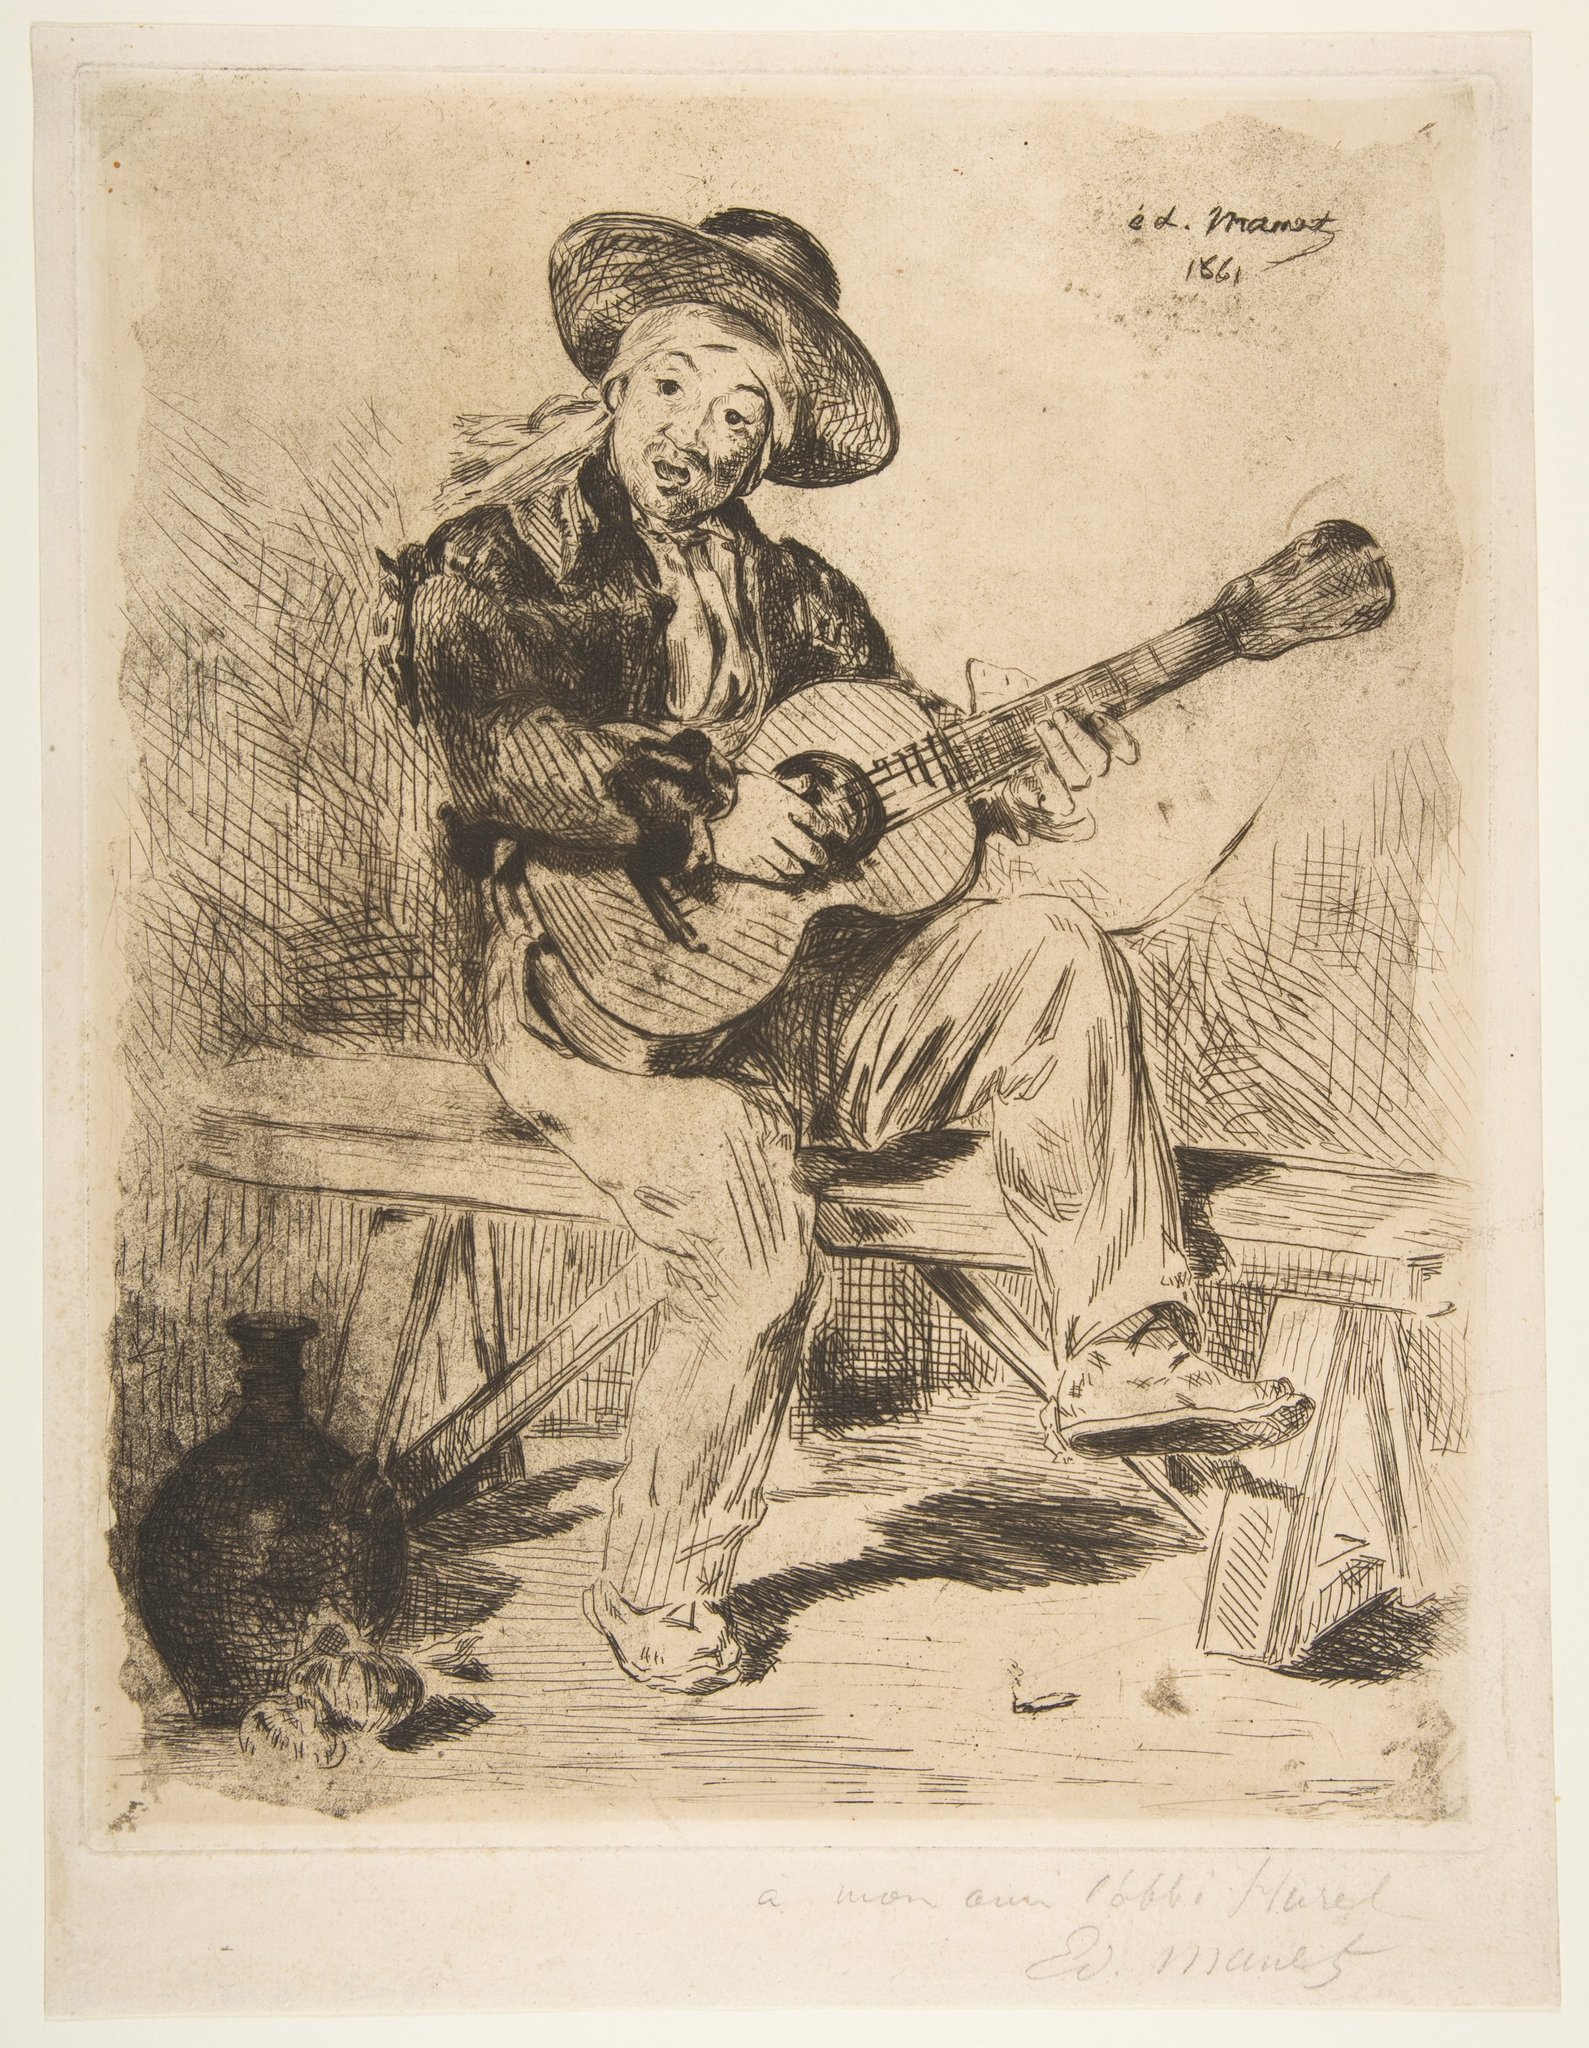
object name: print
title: The Spanish Singer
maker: édouard manet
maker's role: artist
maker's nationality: french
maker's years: 1832-1883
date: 1861-1862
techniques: etching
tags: men,guitars,singers